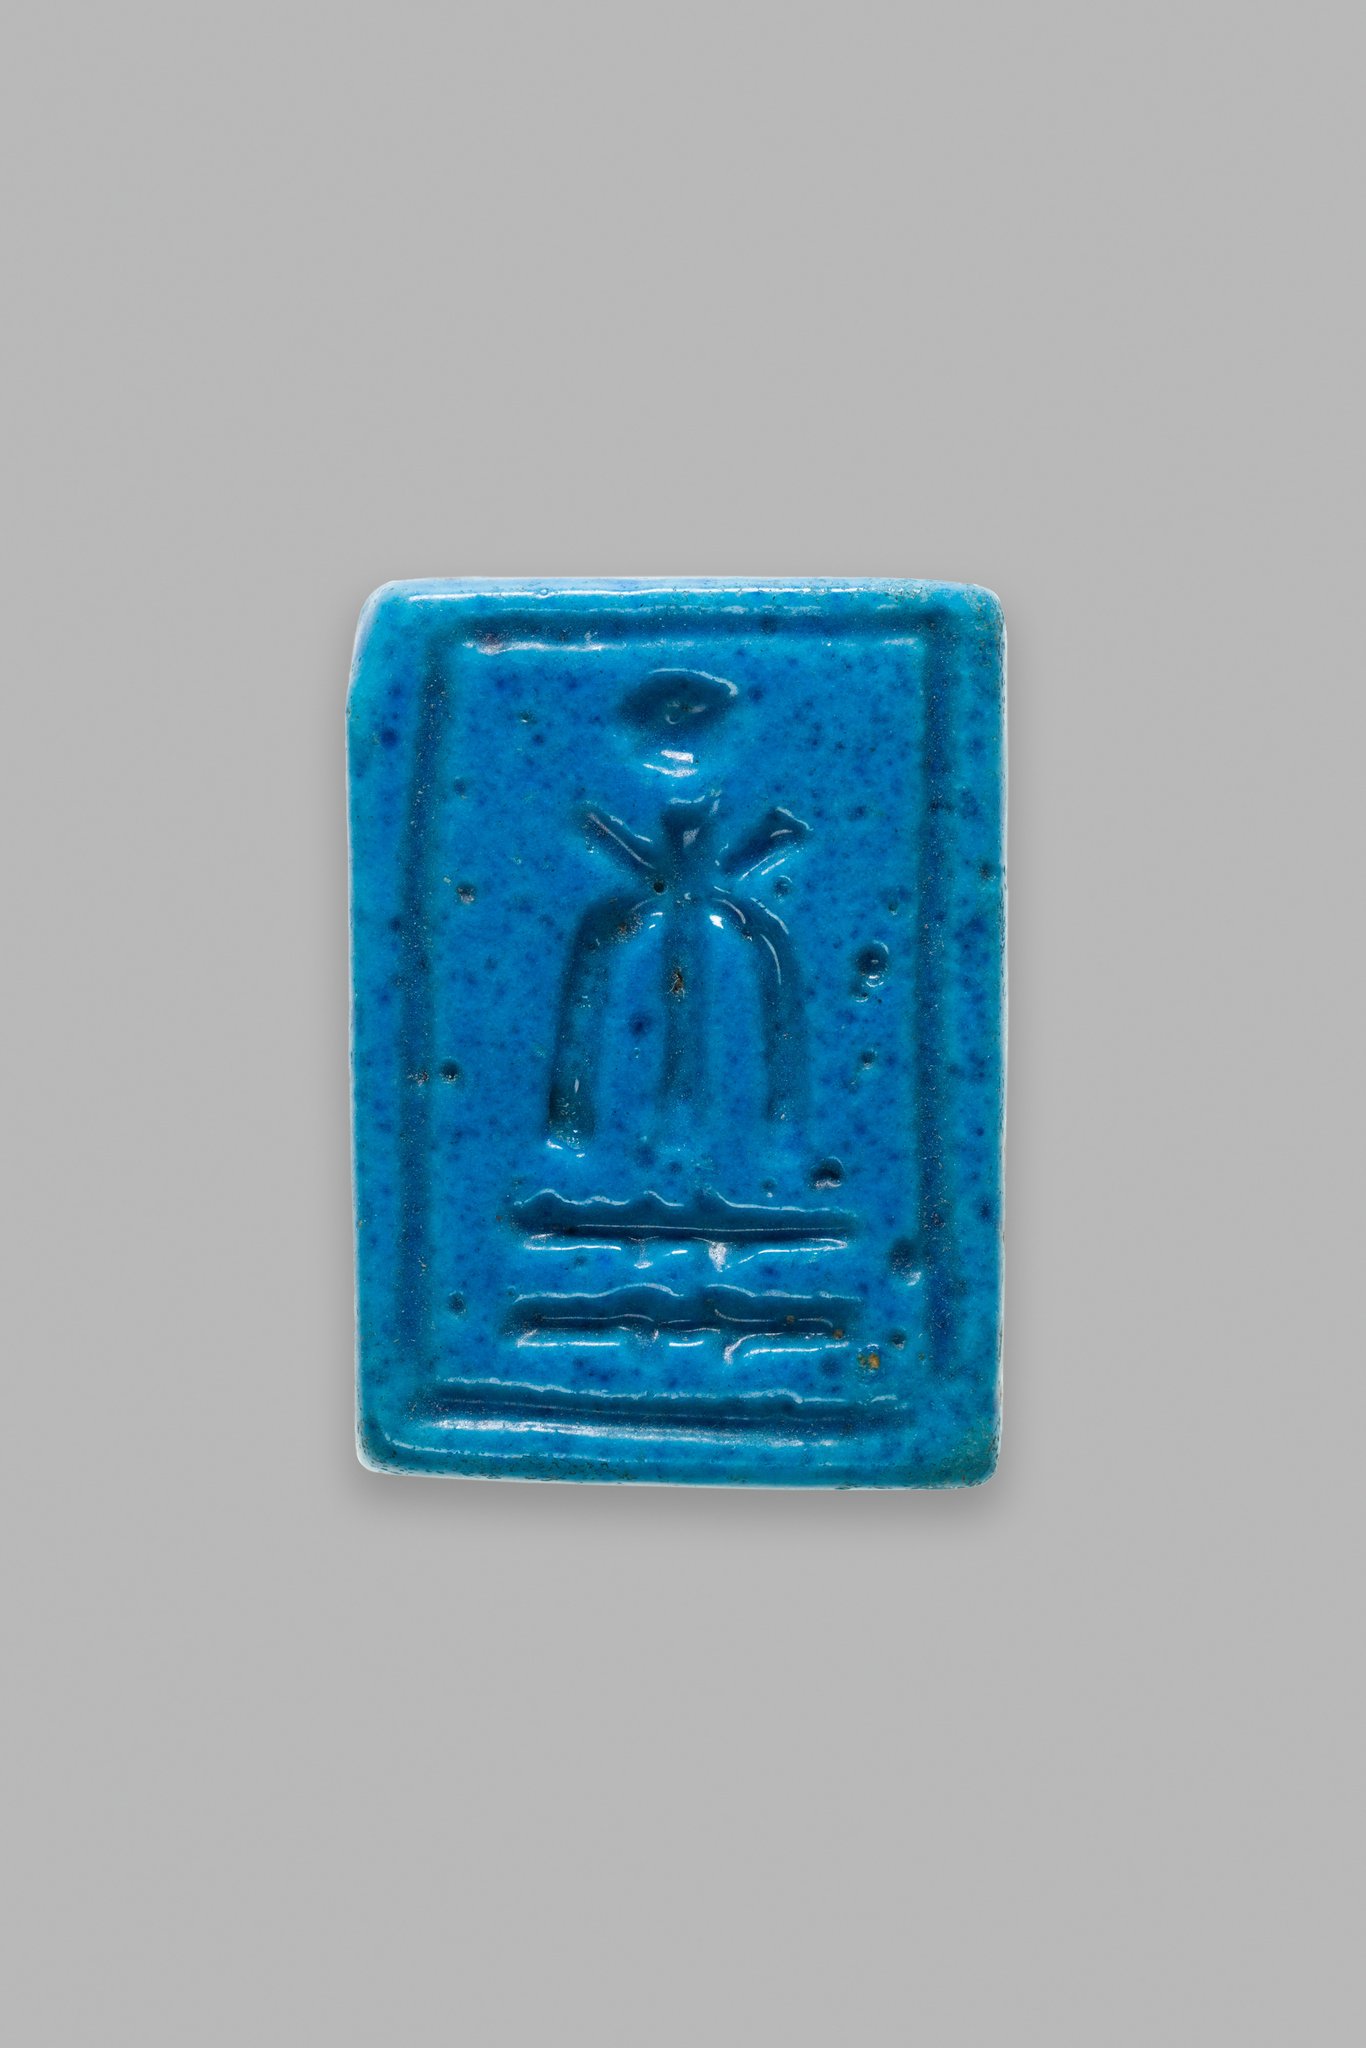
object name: foundation deposit, plaque, rectangular, ramesses iv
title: Inscribed Rectangular Plaque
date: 1153-1147 BCE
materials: faience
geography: egypt